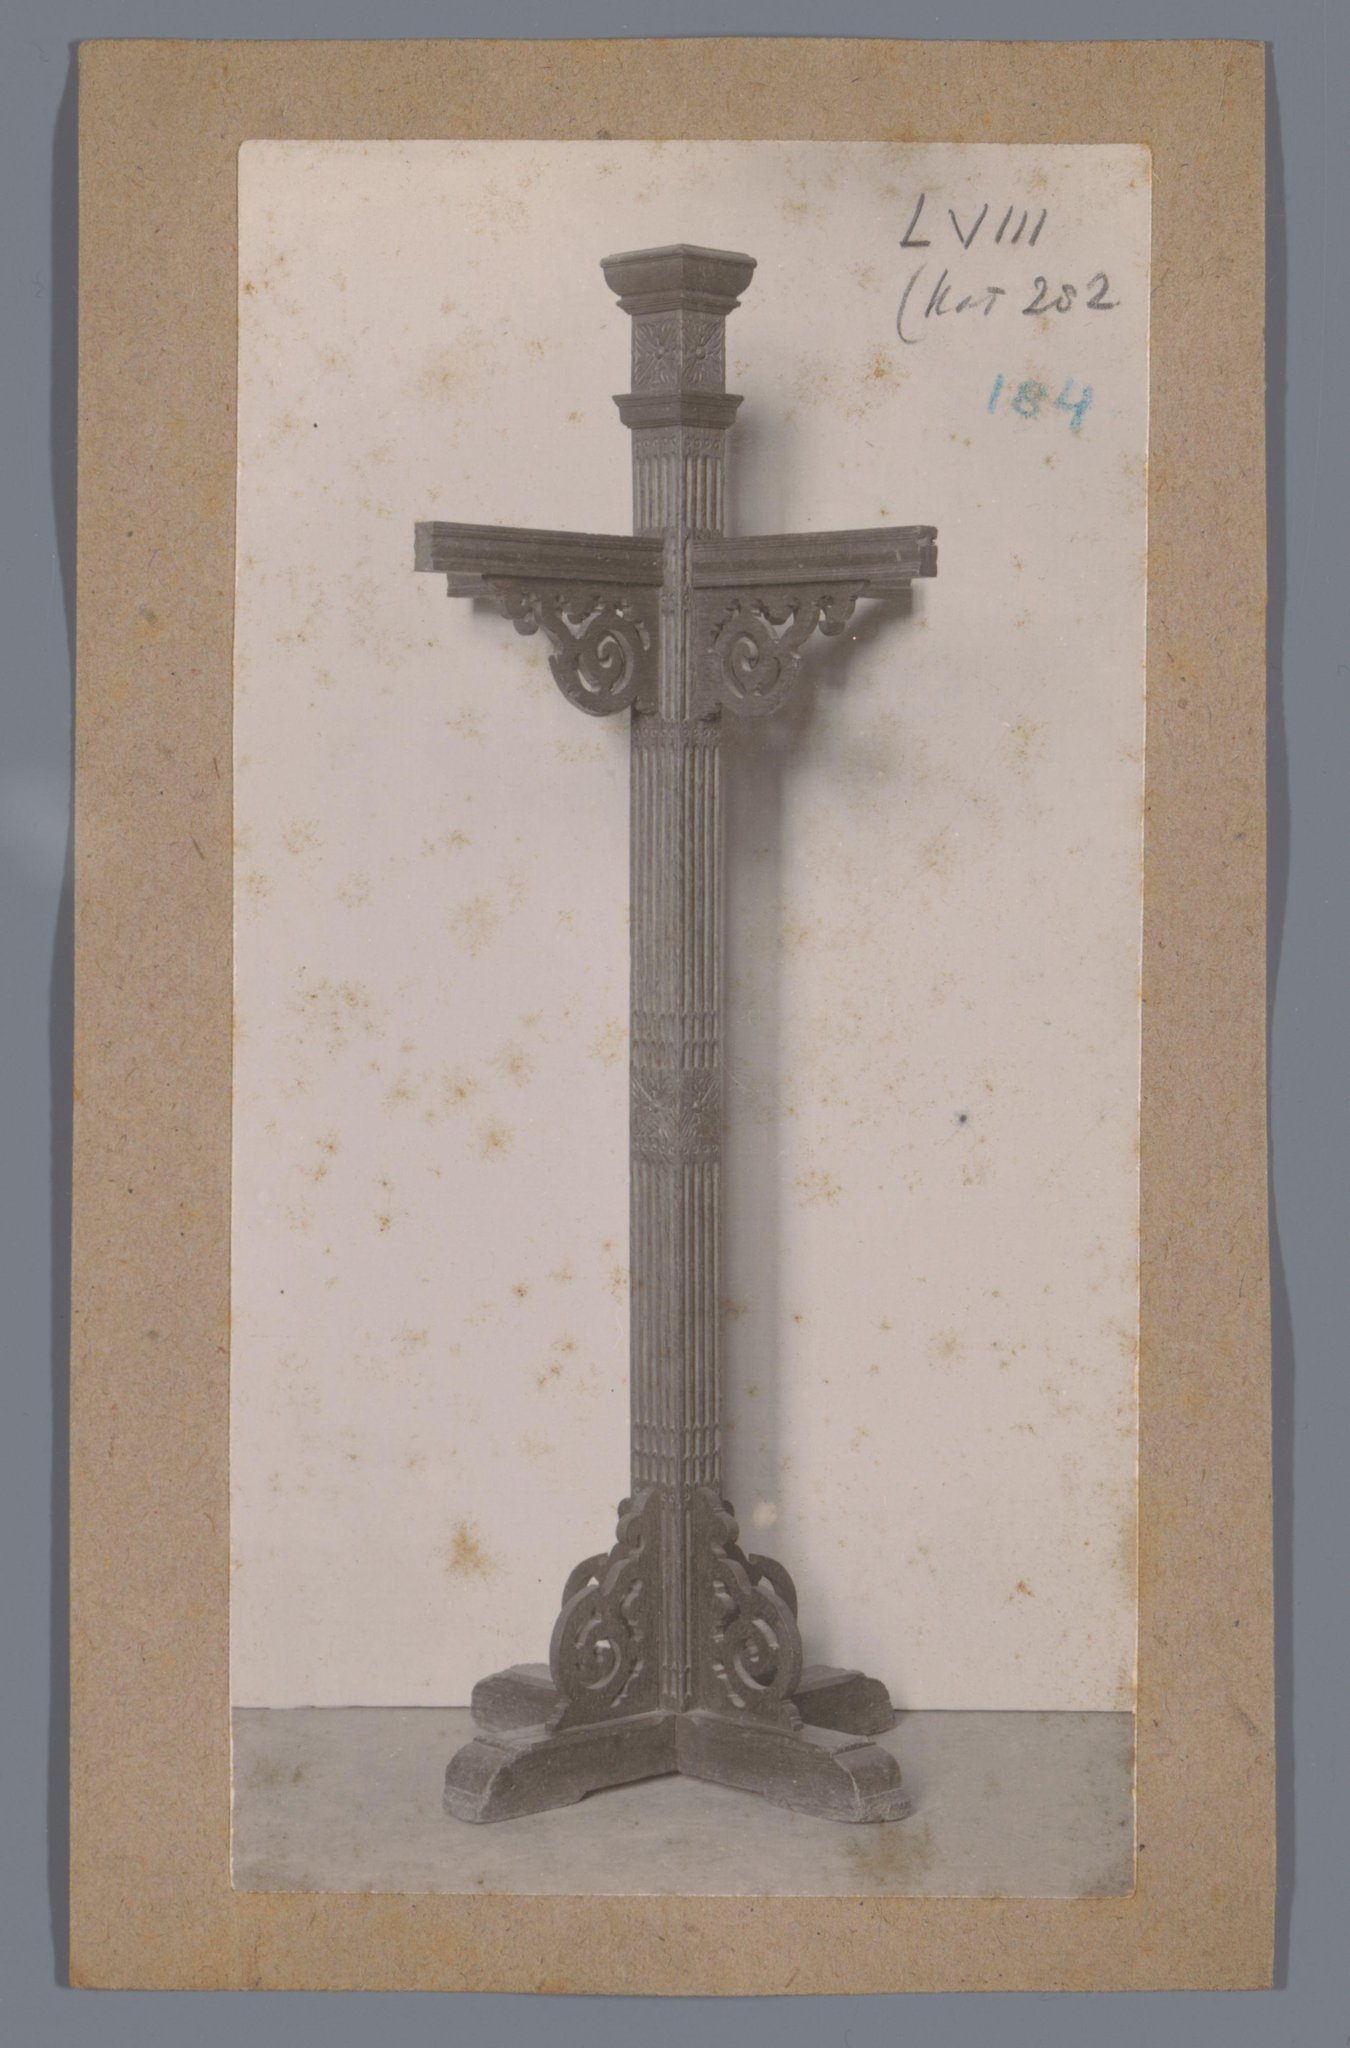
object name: photograph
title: Standaard gedecoreerd met voluten (vermoedelijk) in het Rijksmuseum te Amsterdam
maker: Anonymous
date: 1875-1900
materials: photographic support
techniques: matte daylight collodion silver print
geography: amsterdam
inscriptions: collector's mark: ‘Kunstnijverheidschool Quellinus Amsterdam Frans Halsstraat 14.’, collector's mark: ‘Instituut voor kunst-nijverheidsonderwijs Gabriël Metsustraat No. 16, Amsterdam’, number: ‘LVIII (kat 282 184’